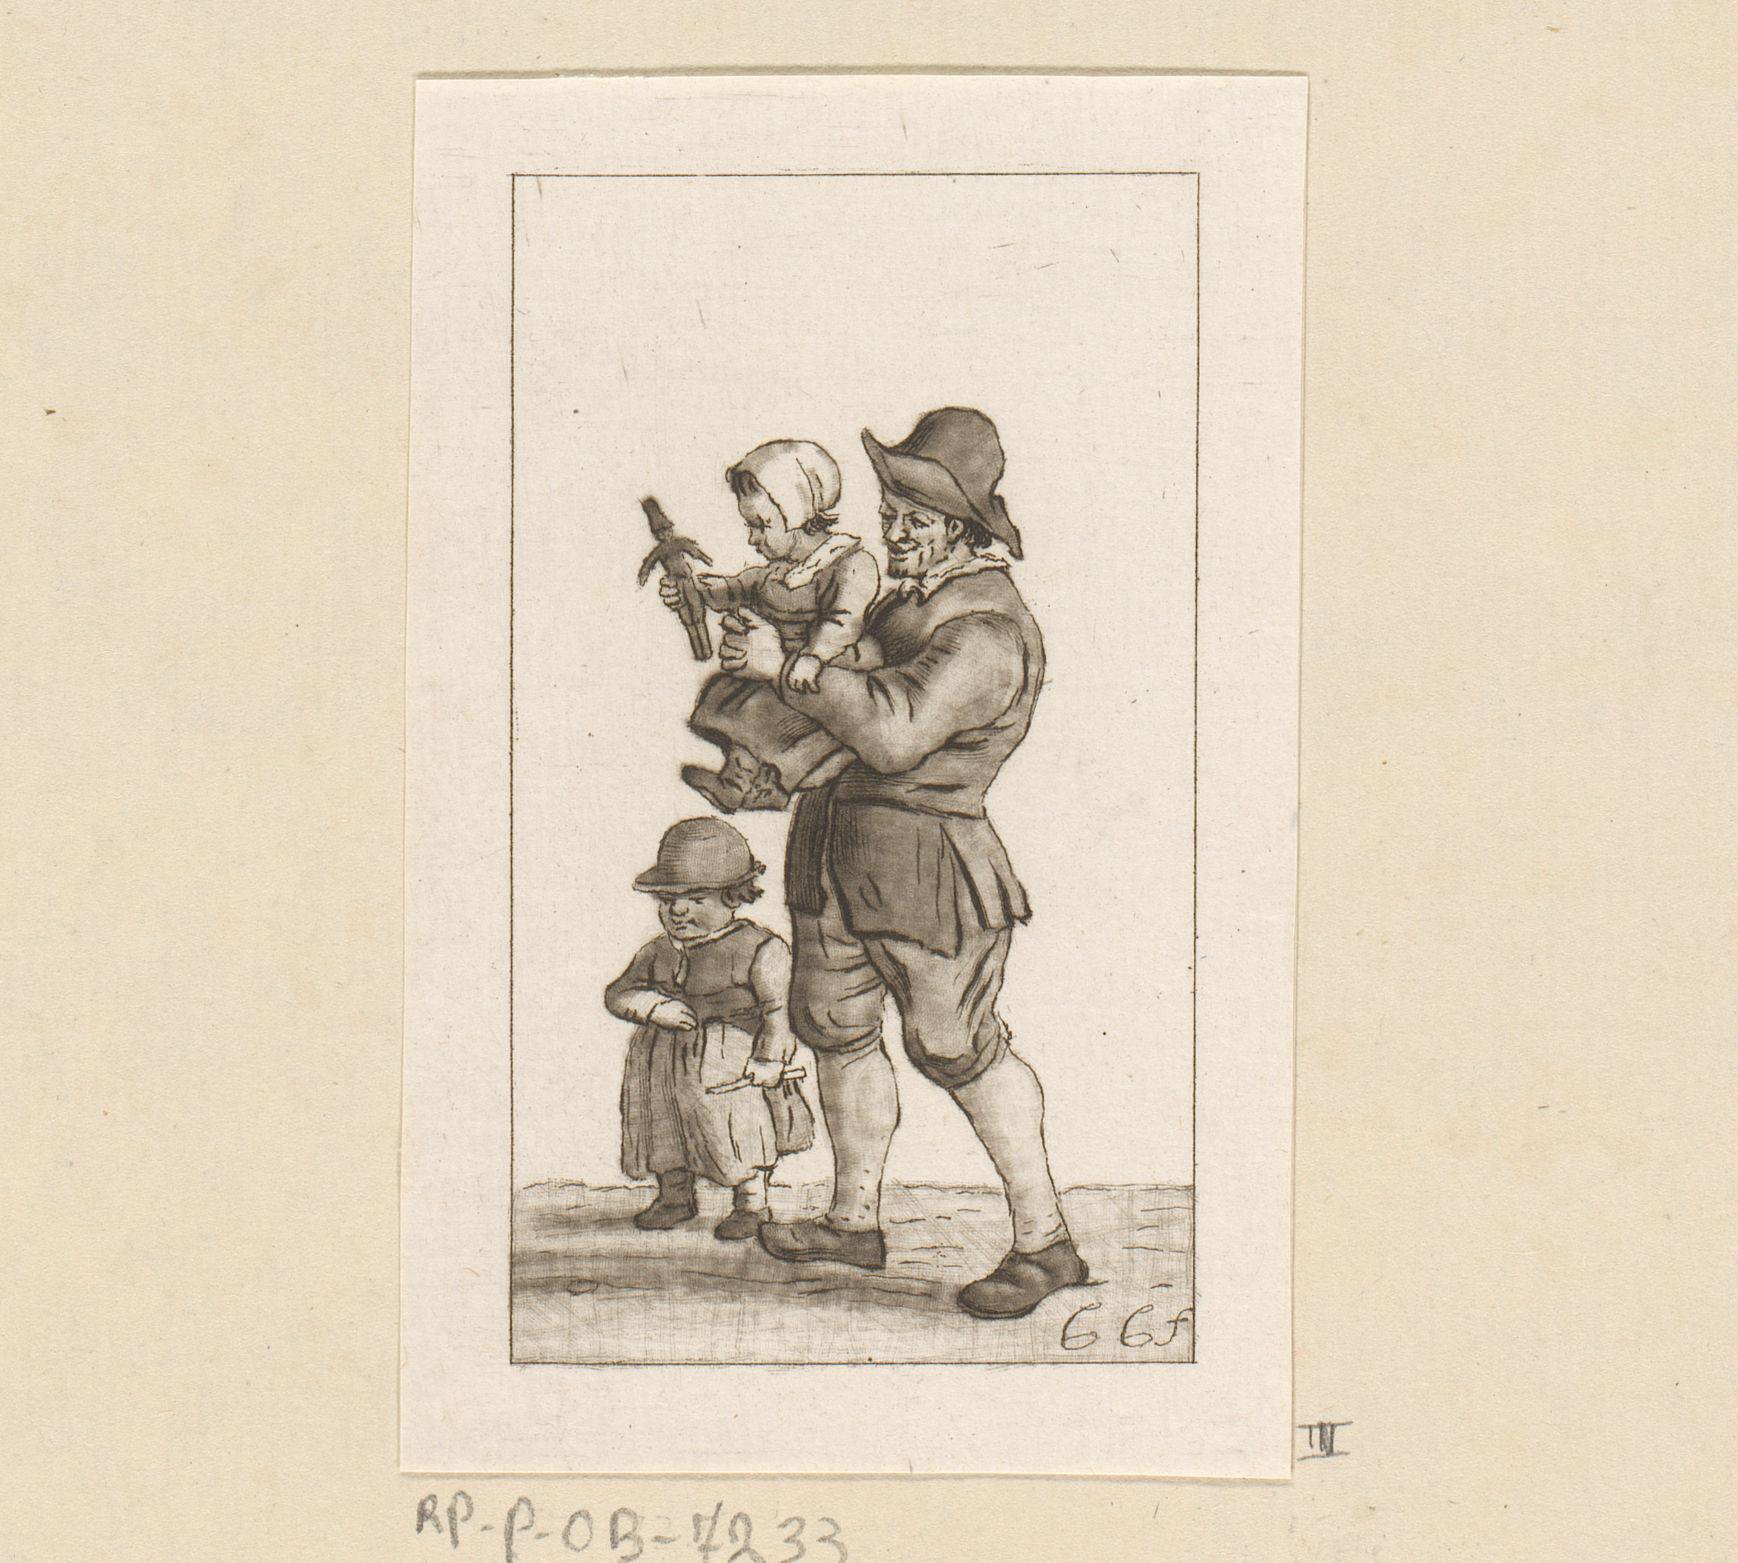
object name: print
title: Vader met twee kinderen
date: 1779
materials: paper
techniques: etching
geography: leiden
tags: father and child(ren), man and child(ren) (family group) (with number of children)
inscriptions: collector's mark: Lugt 2228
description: Een vader speelt met zijn twee kinderen. Een van de kinderen staat naast de man terwijl de andere wordt opgepakt door haar vader.